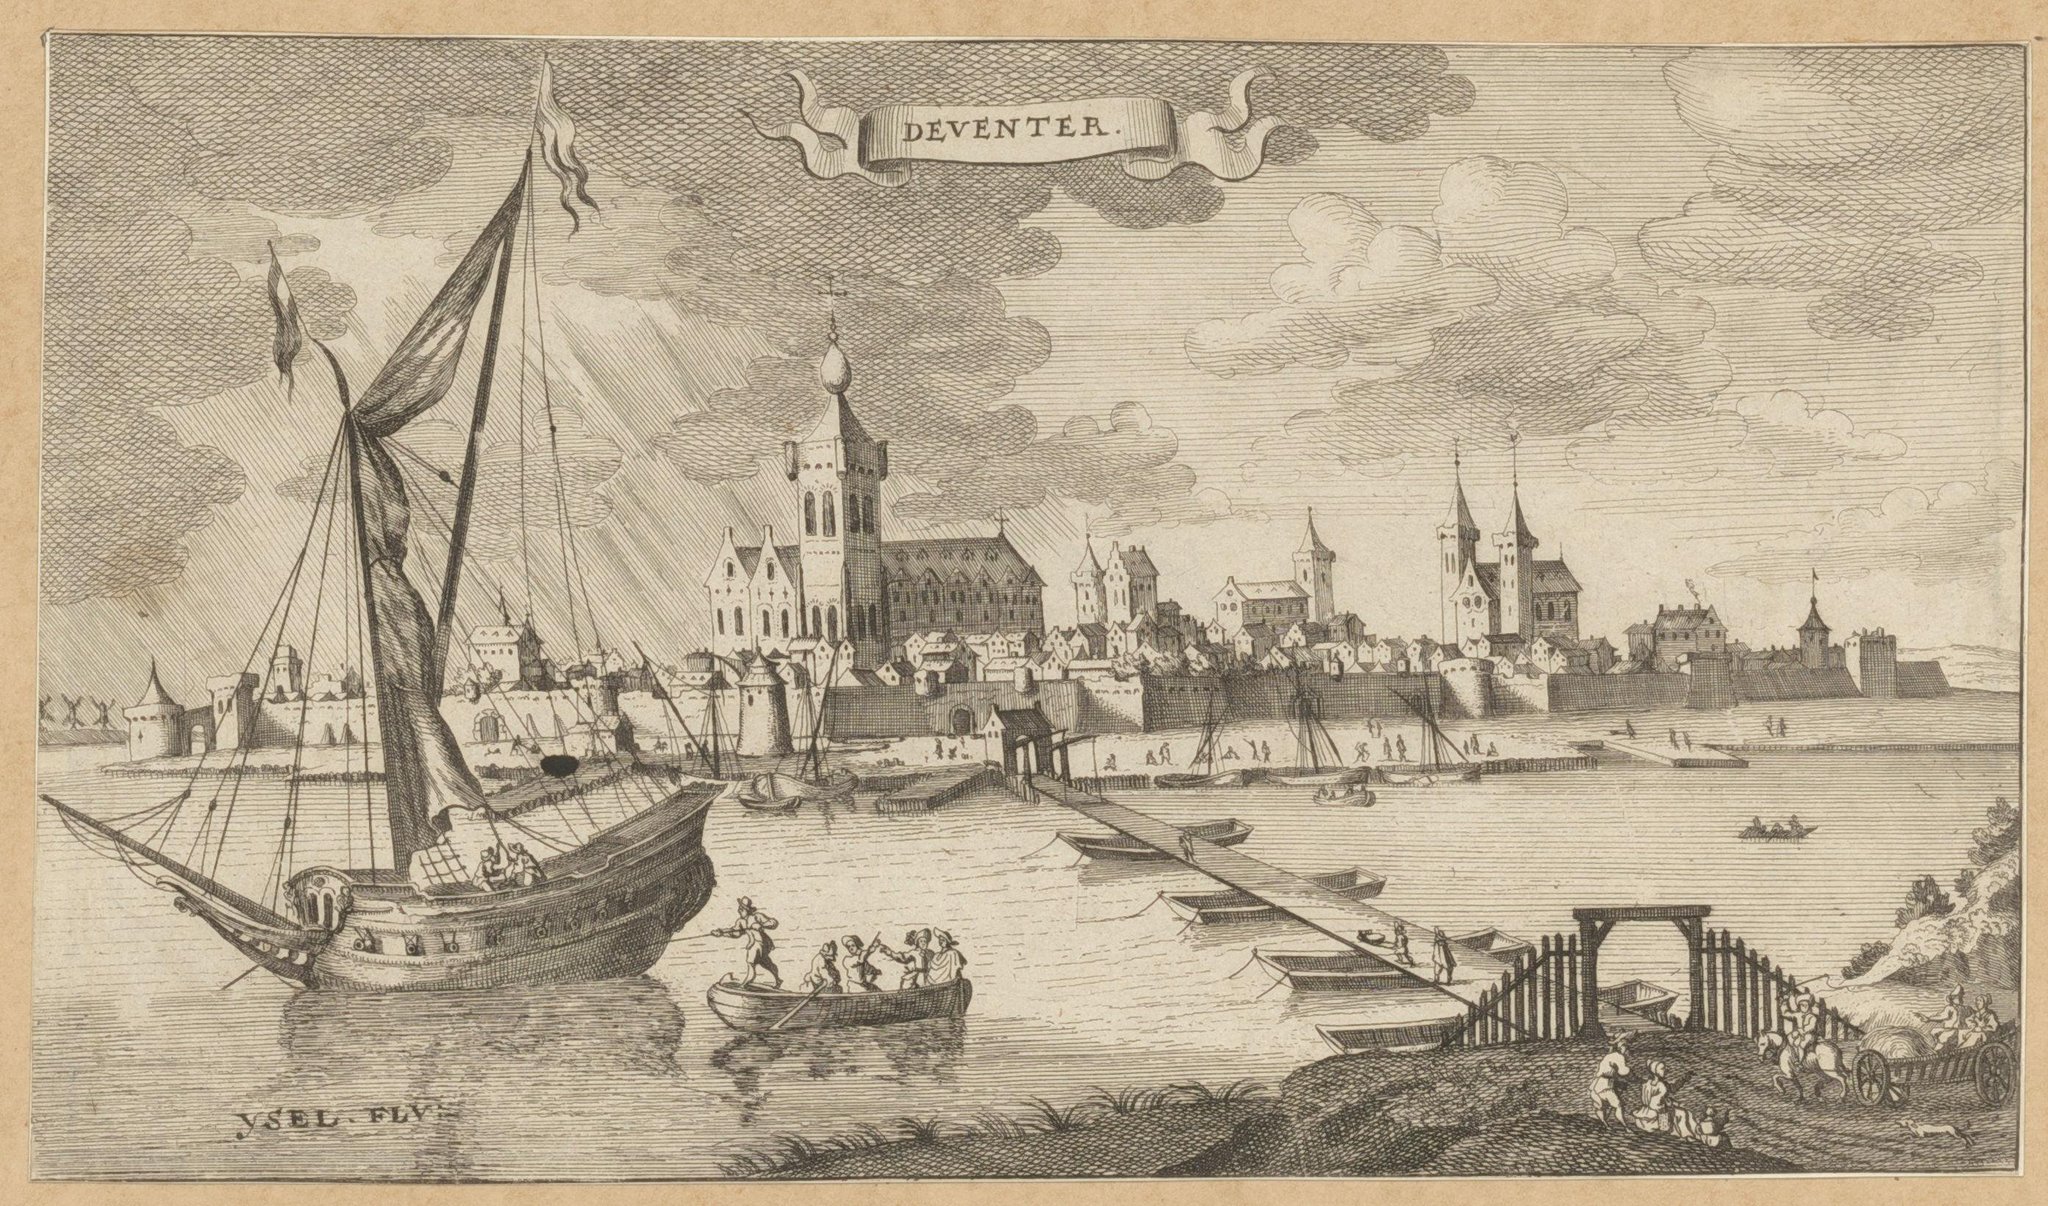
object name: print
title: Gezicht op Deventer en de IJssel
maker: gaspar bouttats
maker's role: print maker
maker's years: 1640-1695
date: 1679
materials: paper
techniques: etching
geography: antwerp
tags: city-walls, geographical names of countries, regions, mountains, rivers, etc., bridge, prospect of city, town panorama, silhouette of city, deventer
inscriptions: collector's mark: Lugt 1641, stamp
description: Gezicht op de stad Deventer. Op de voorgrond, buiten de stadsmuren, de rivier De IJsel. Een sloep brengt passagiers naar een zeilschip. Wandelaars en karren gaan over de brug richting Deventer. Boven het stadsgezicht een cartouche met de naam van de stad. De prent heeft een Nederlands en Frans onderschrift. Onderwerpsrubrieken binnen de Atlas Zeden en Gewoonten: Handel, Nijverheid en Verkeer, Scheepsvaart.